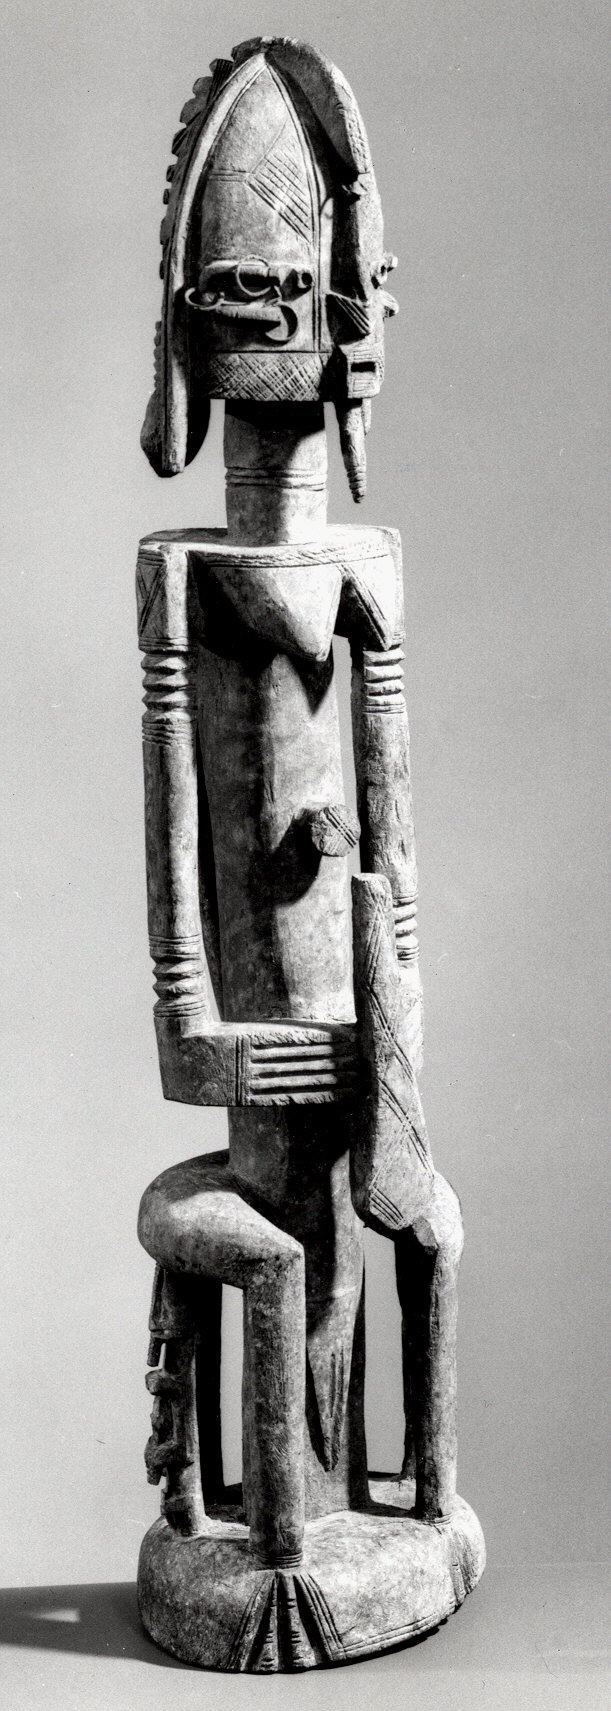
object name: female figure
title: Figure: Seated Female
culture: dogon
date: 1501-1900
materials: metal, wood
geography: mali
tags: women